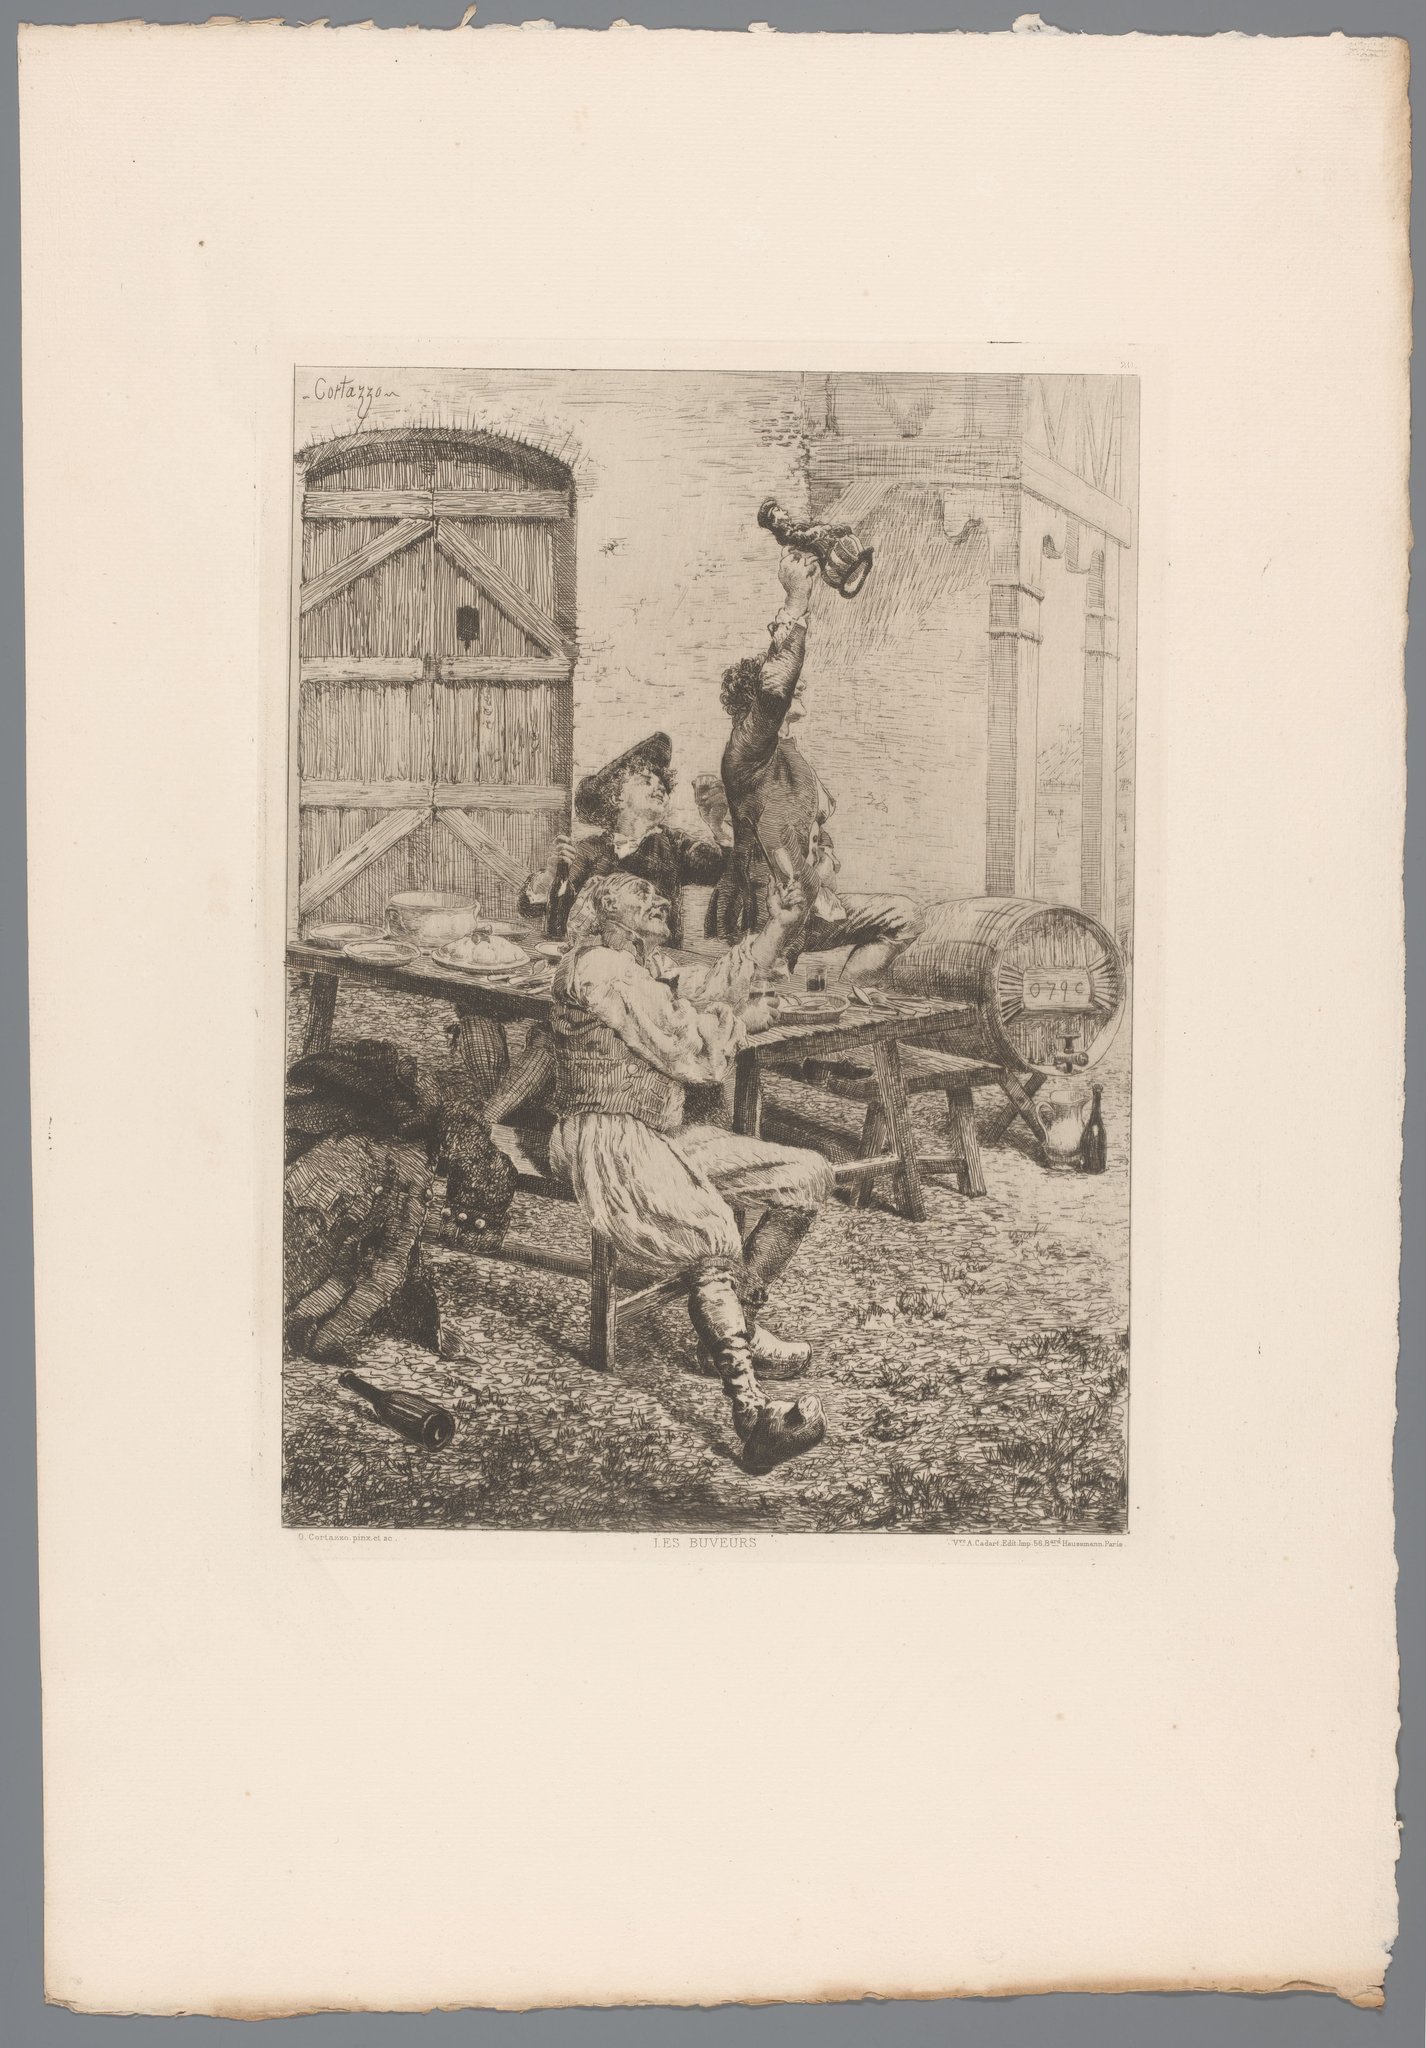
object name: print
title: Les buveurs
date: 1880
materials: paper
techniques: drypoint, etching, intaglio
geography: paris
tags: inn, coffee-house, public house, etc., alcoholic drinks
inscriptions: collector's mark: Lugt 2760, collector's mark: ‘AFE v S’, watermark, collector's mark: Lugt 2228